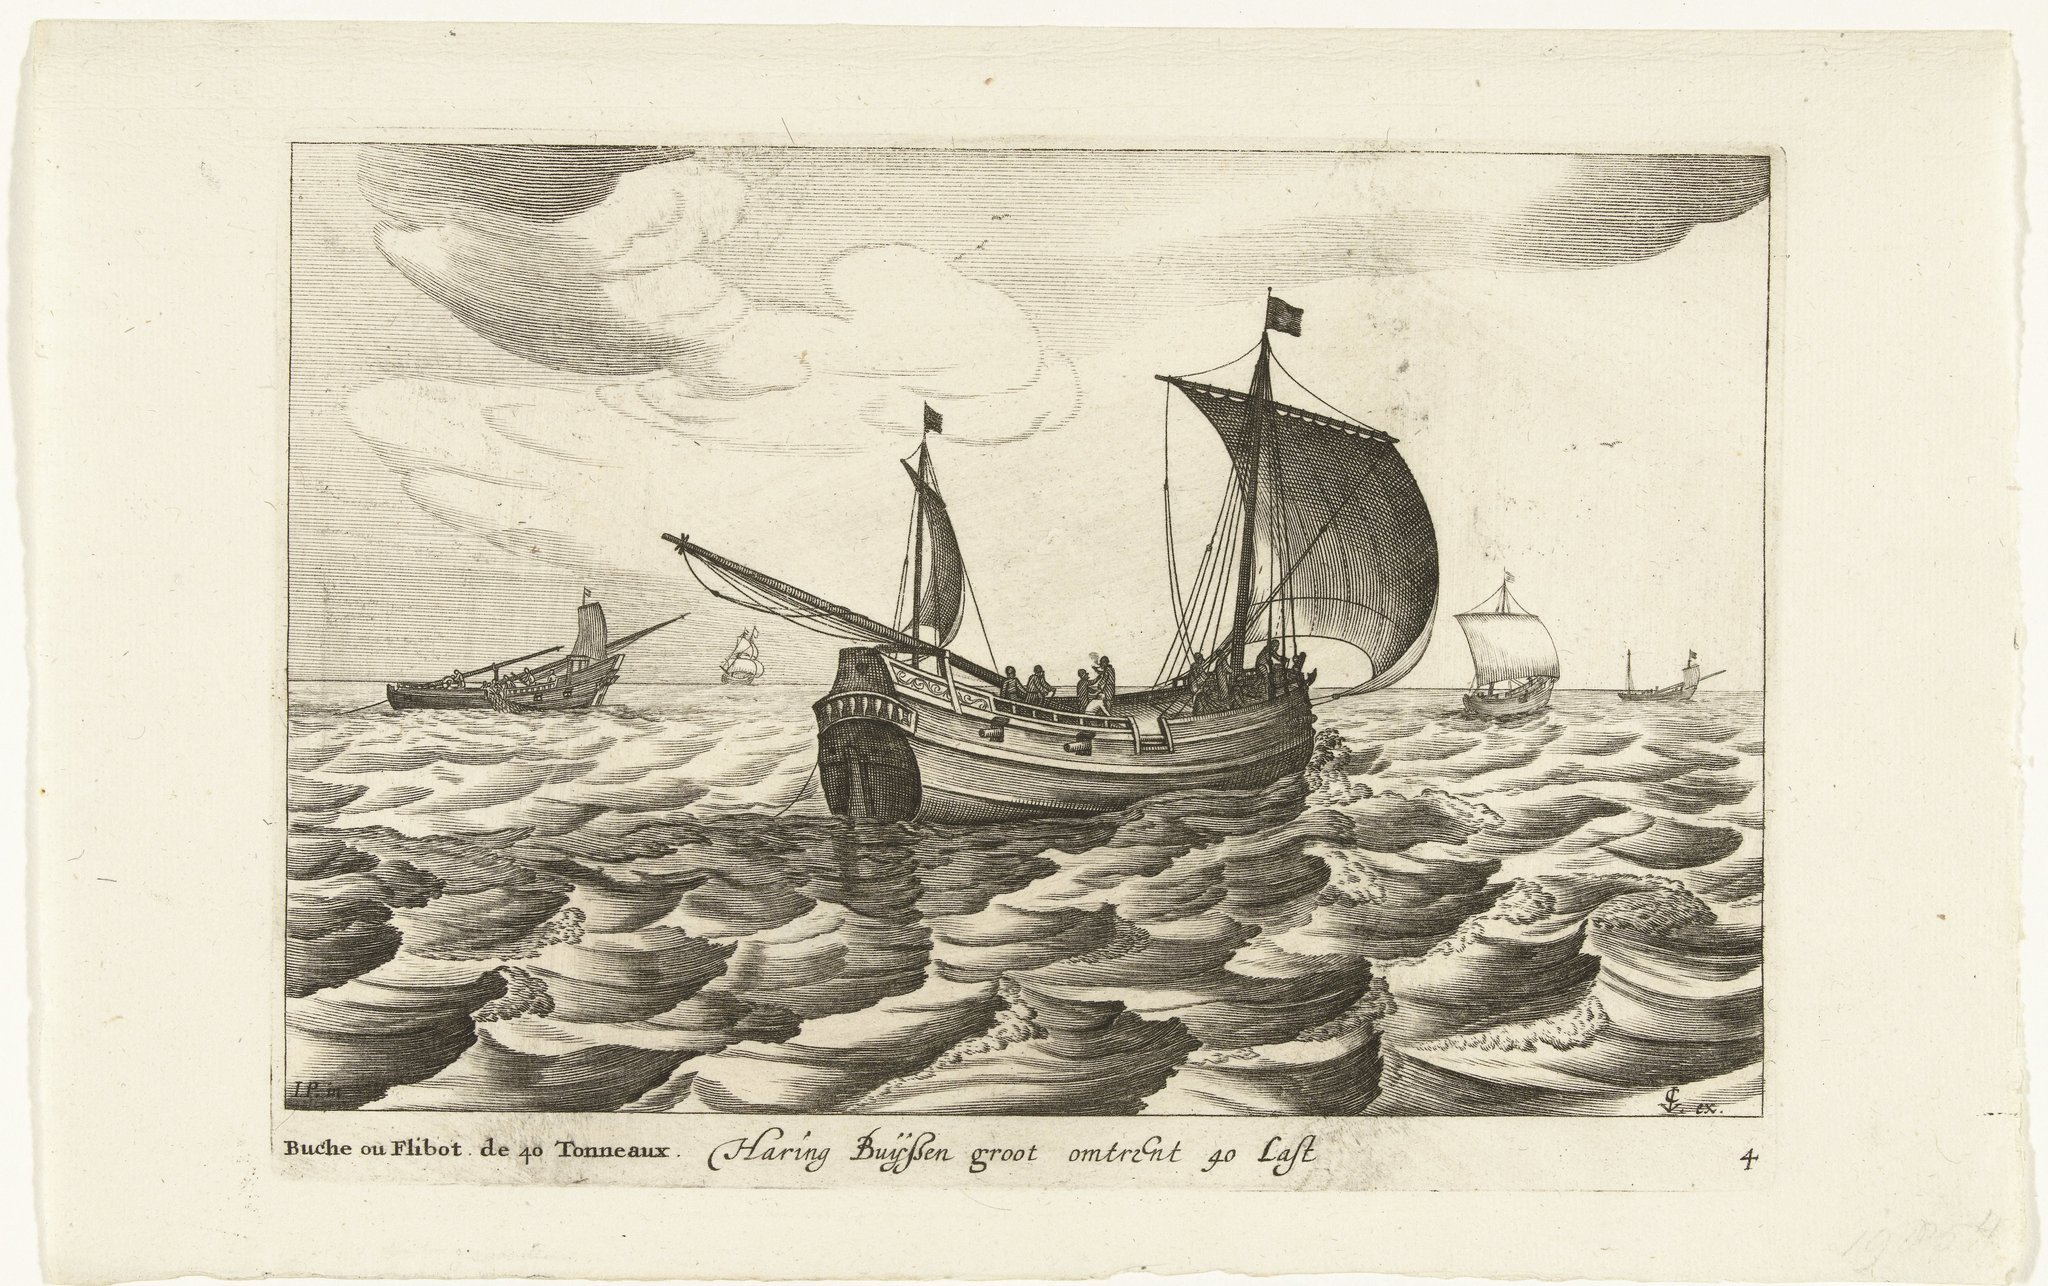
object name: print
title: Haringbuizen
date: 1627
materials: paper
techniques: engraving, etching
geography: haarlem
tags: sailing-ship, sailing-boat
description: Haringbuizen aan het vissen op zee. Prent nr. 4 in een serie prenten van Hollandse scheepstypen, 1627. .